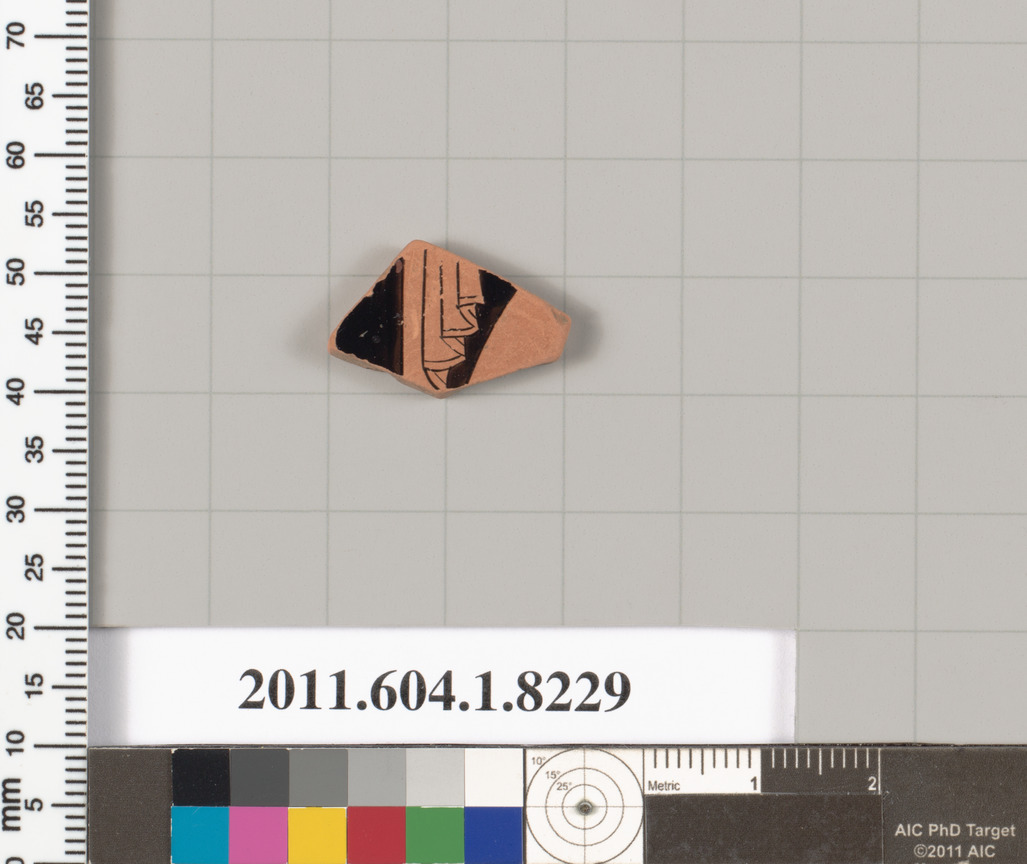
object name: kylix fragment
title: Terracotta fragment of a kylix (drinking cup)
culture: greek, attic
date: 520-510 BCE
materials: terracotta